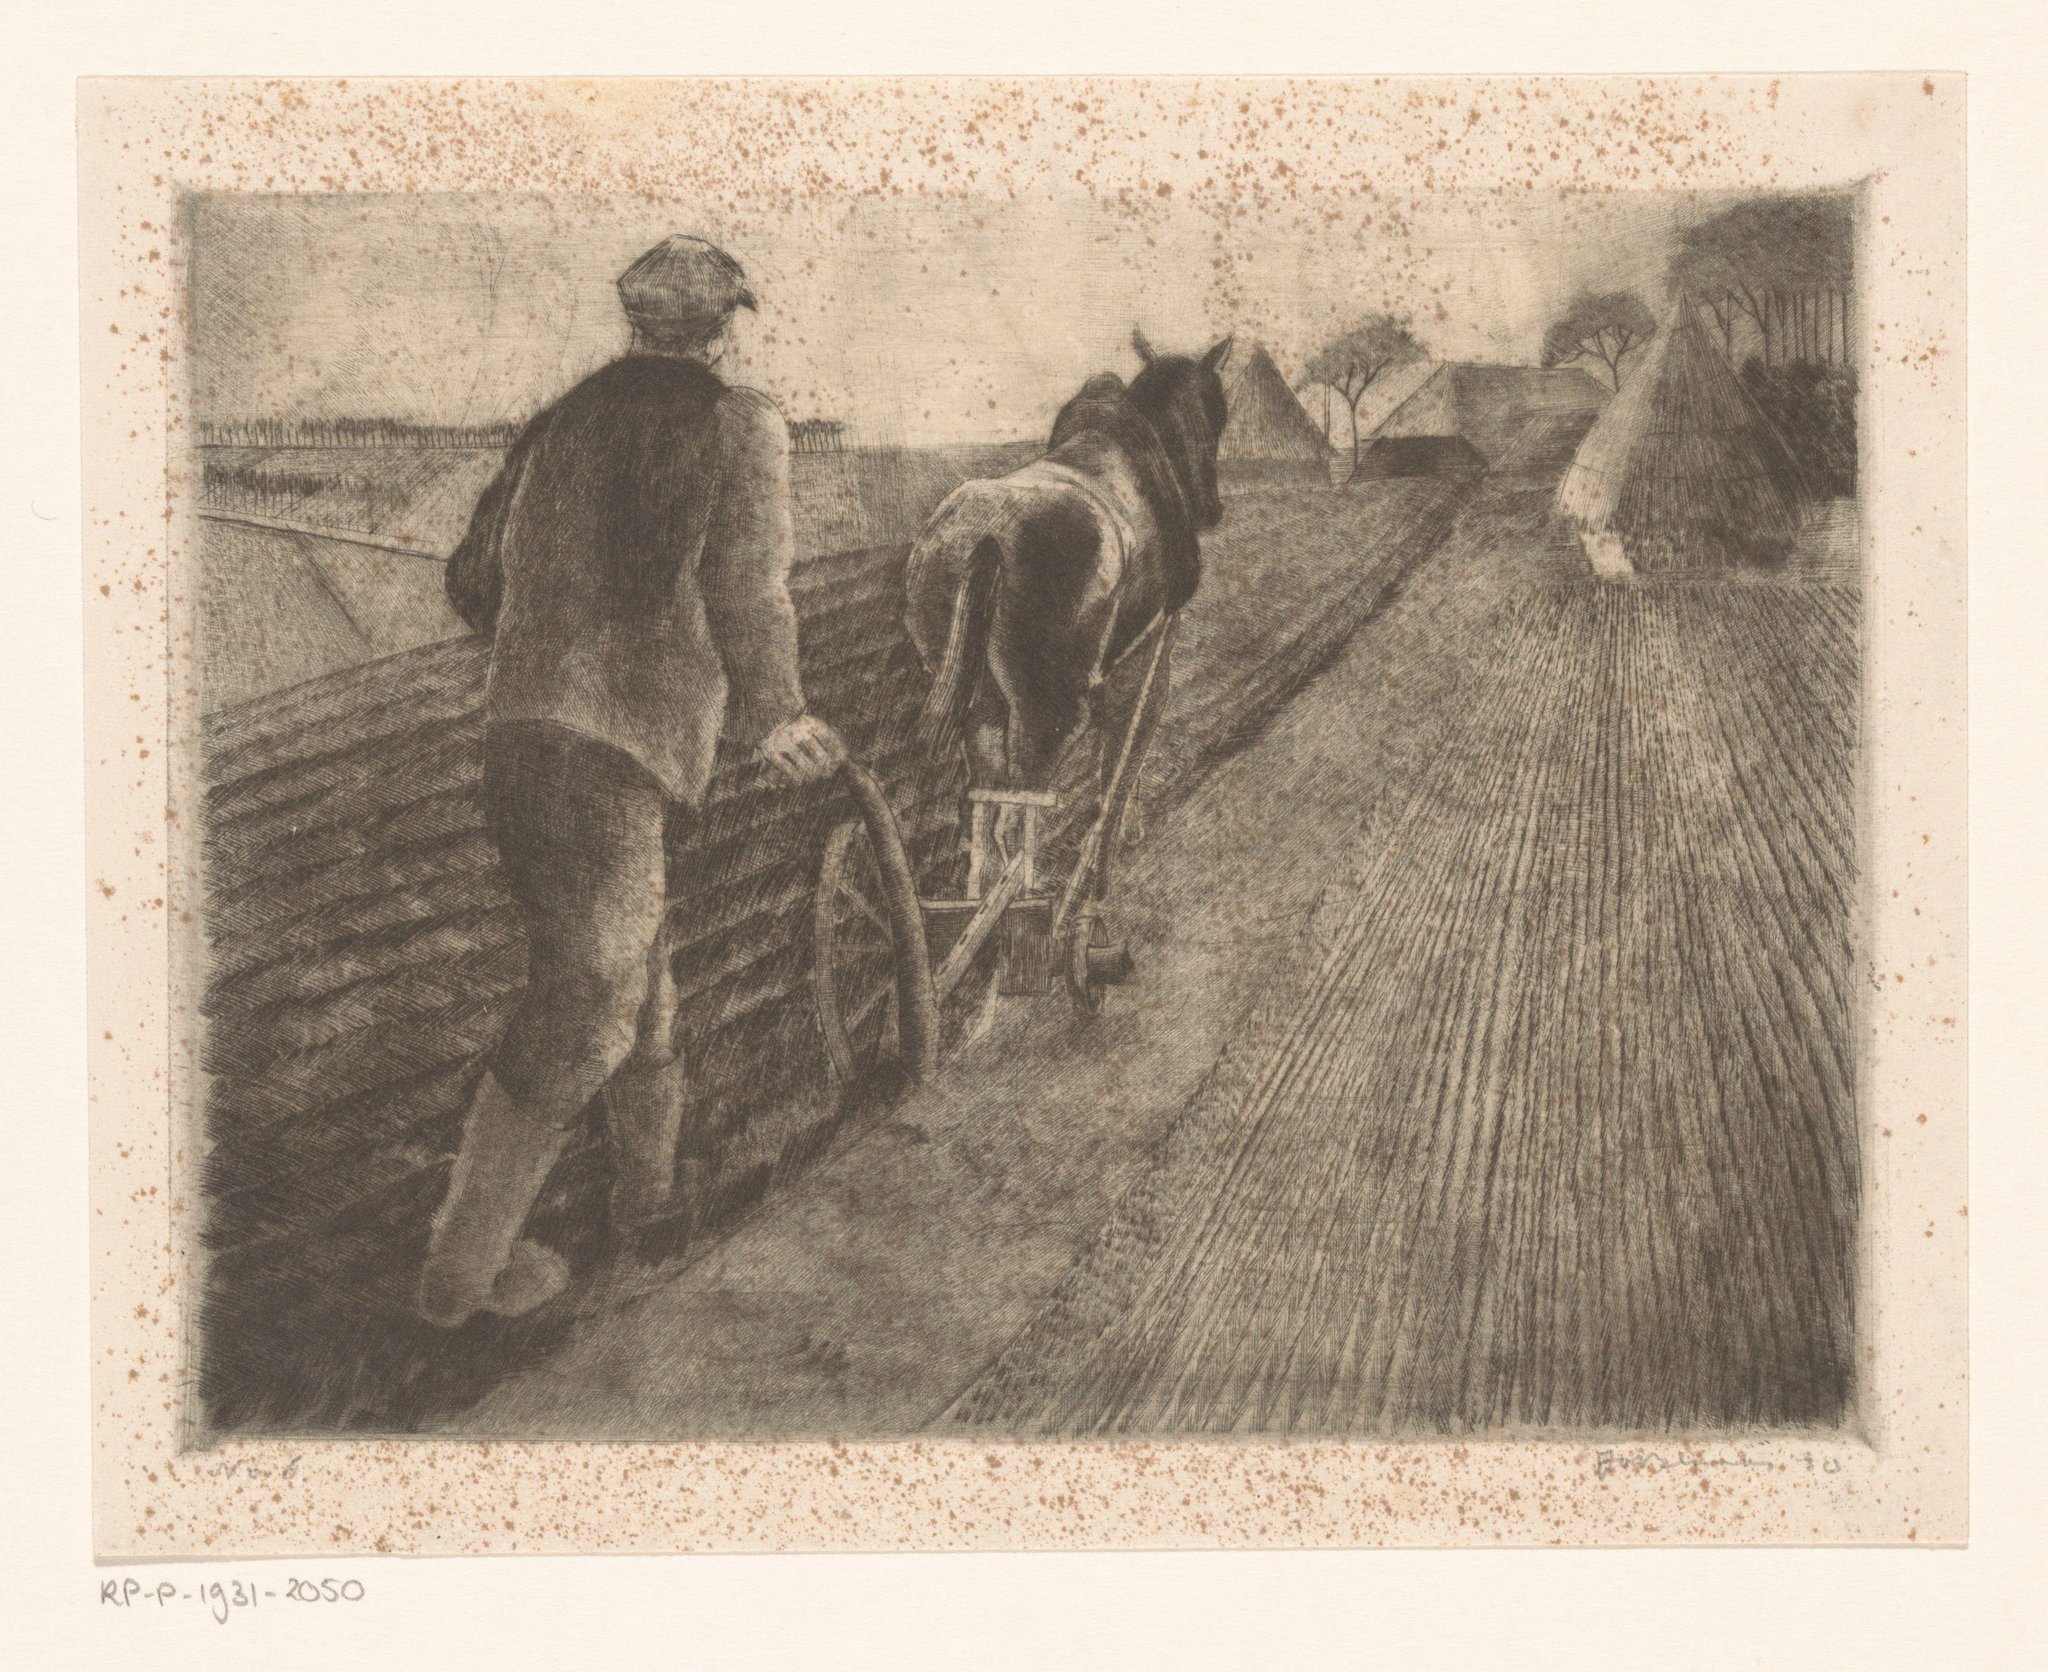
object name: print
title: Ploeger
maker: jo bezaan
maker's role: draughtsman, print maker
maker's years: 1894-1952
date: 1930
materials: paper, ink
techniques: drypoint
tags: ploughing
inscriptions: collector's mark: Lugt 2228, signature and date: ‘JoBezaan ´30’, number: ‘Nr. 6’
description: Paard en een ploeger, op de rug gezien, aan het werk op een akker met een schuur.